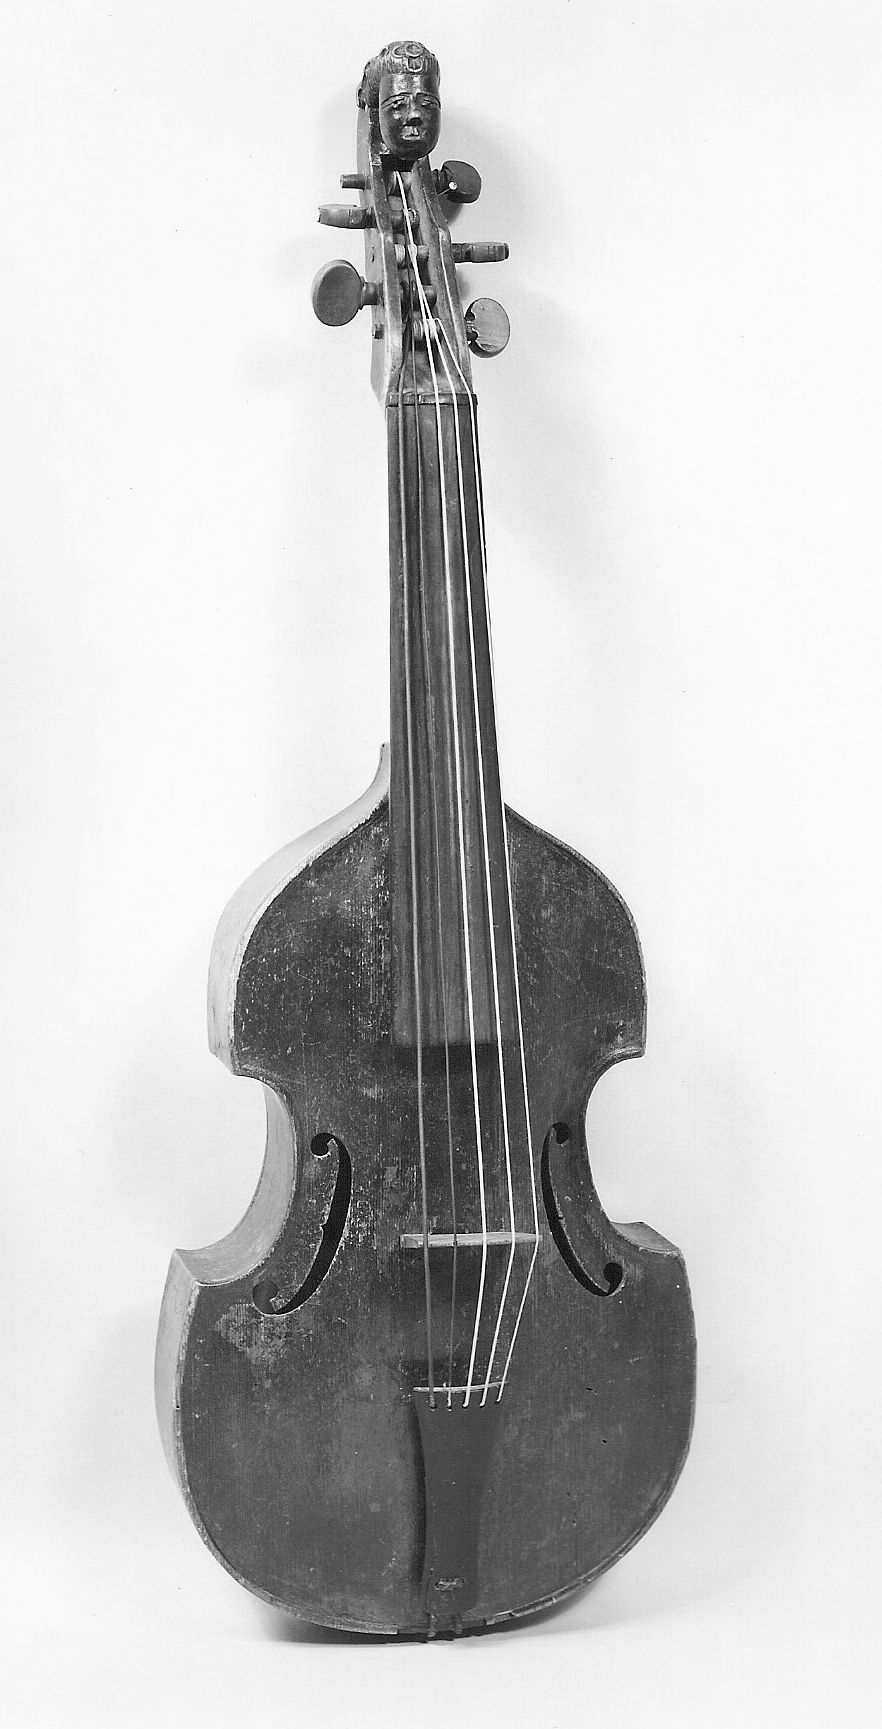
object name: quinton in viol form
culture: french or german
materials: wood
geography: france or germany